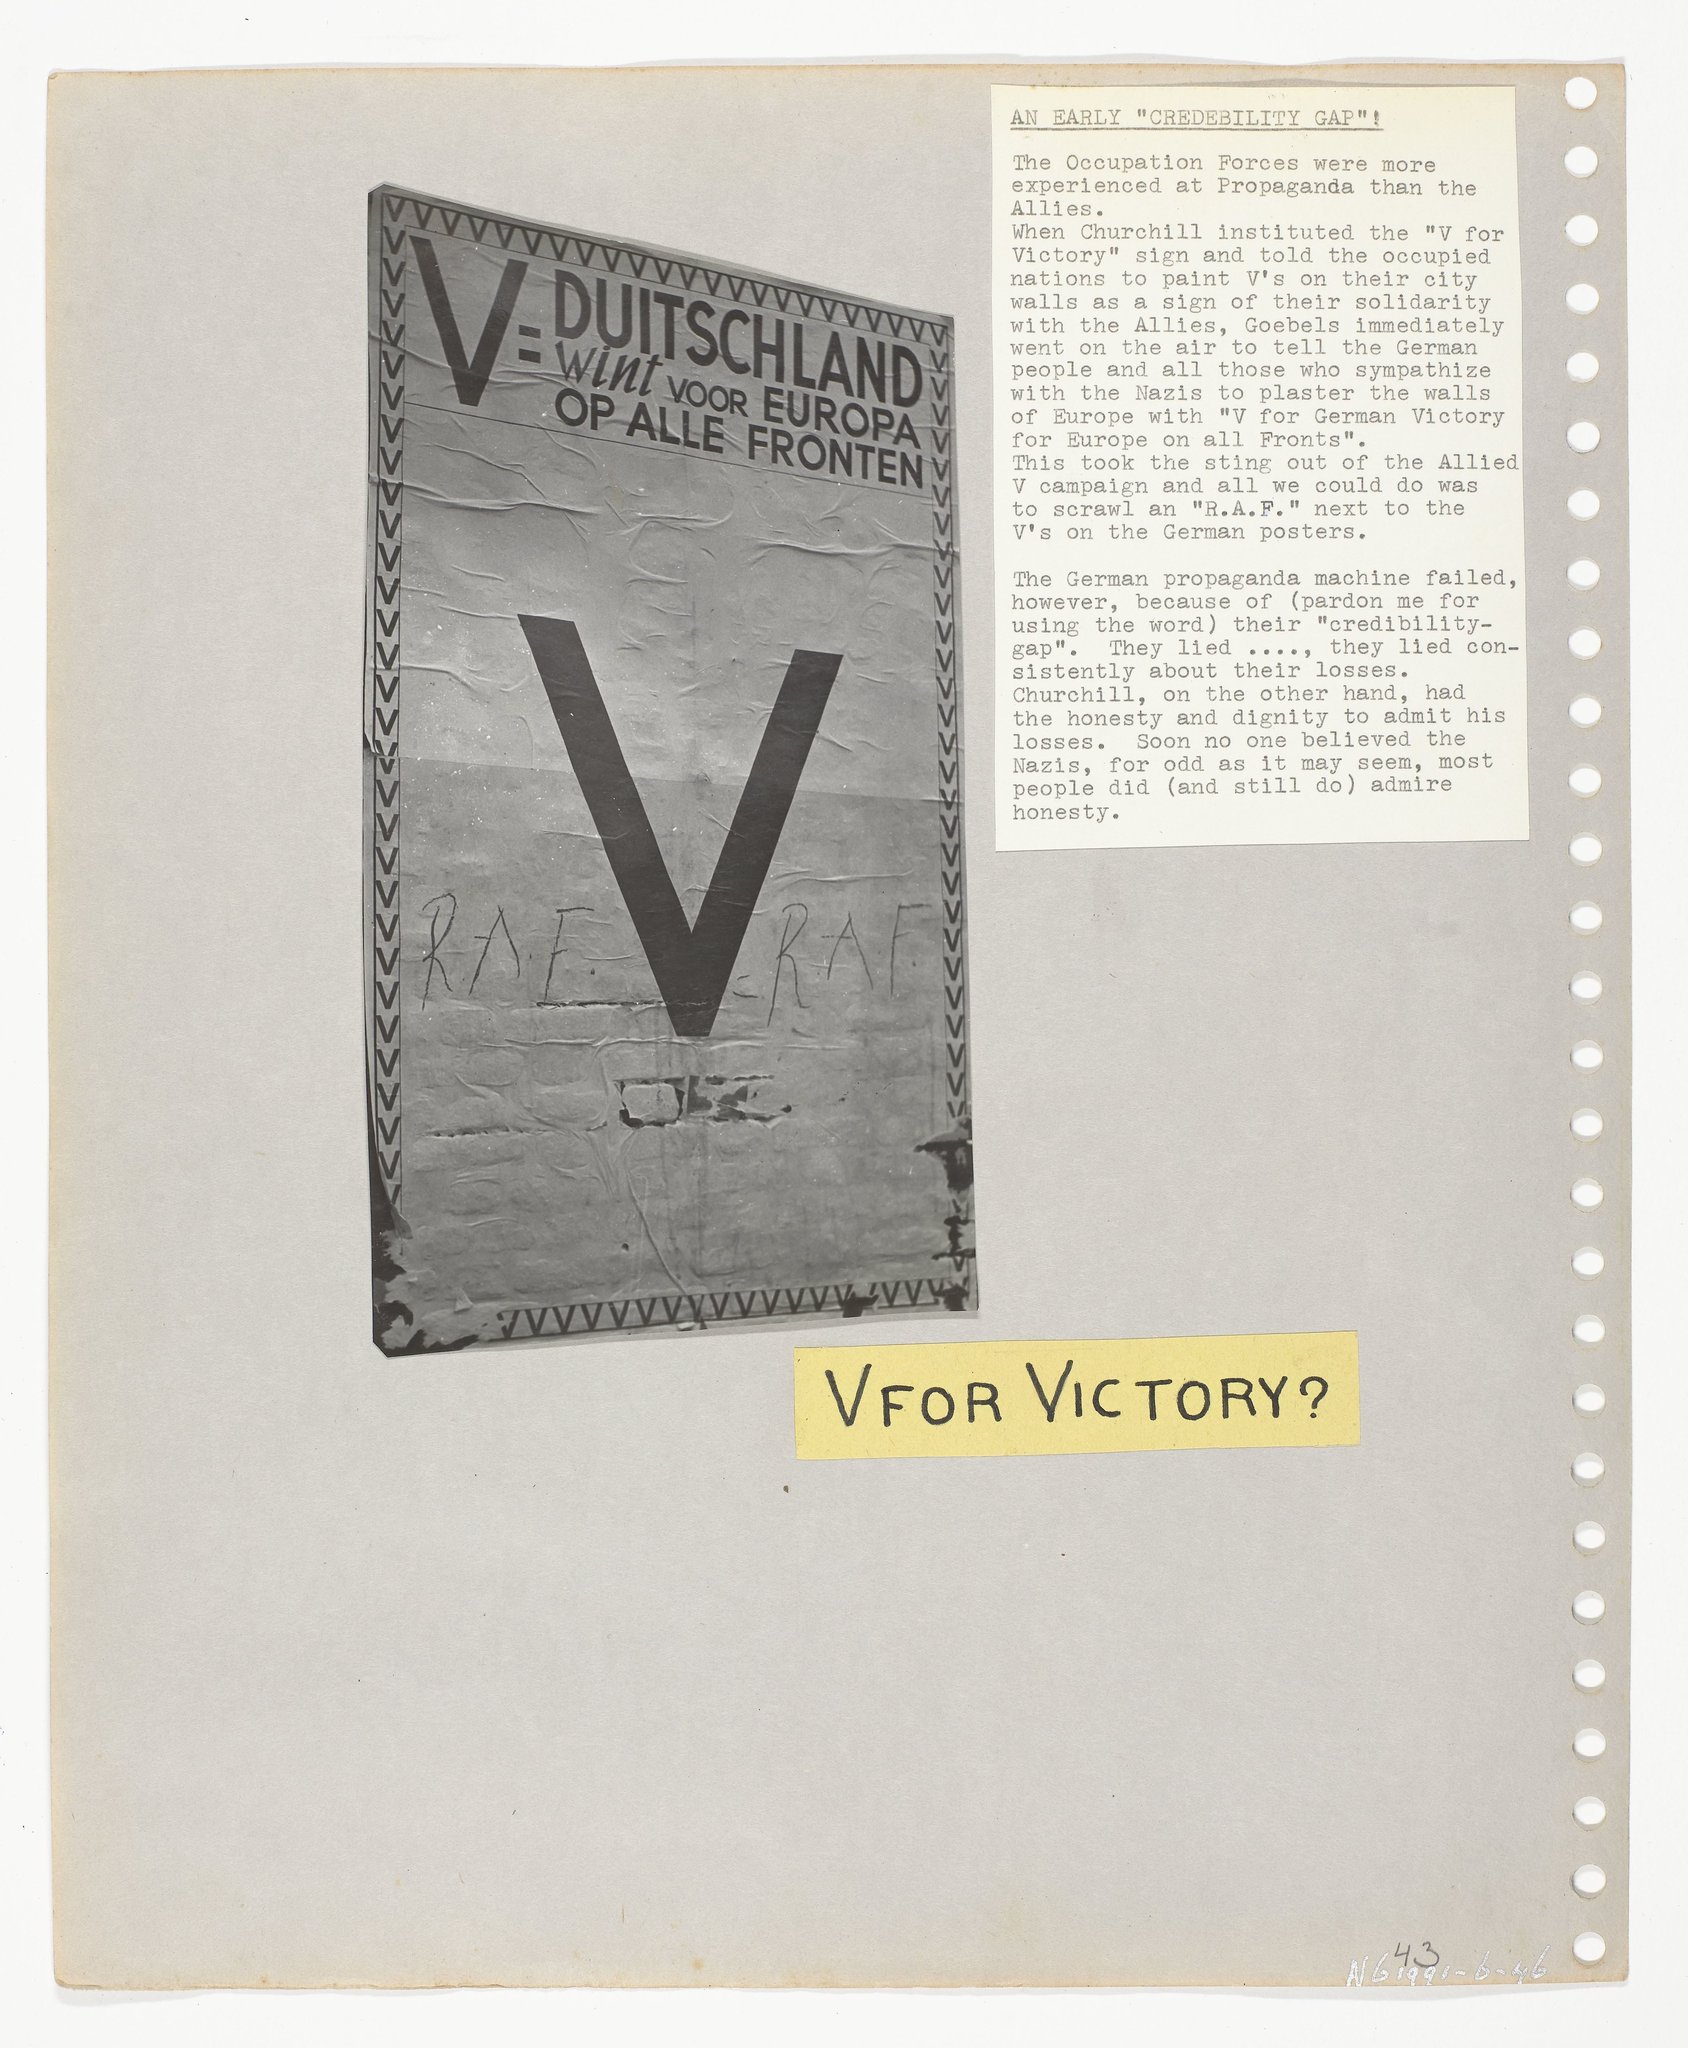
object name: photograph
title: V = Victorie/ Viktorie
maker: Anonymous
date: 1943-1945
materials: paper, plastic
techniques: photography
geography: netherlands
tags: amsterdam, tonny van renterghem, berlin, fritz kahlenberg, underground movement, partisans, netherlands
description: Foto van een Duits aanplakbiljet om propaganda te maken voor de Duitse overwinning: V = (Viktorie ) Duitsland wint voor Europa op alle fronten. De V = Victory campagne werd door Churchill begonnen maar al snel door de Duitsers geannexeerd. Naast de V heeft iemand de letters RAF (Royal Air Force) geschreven.